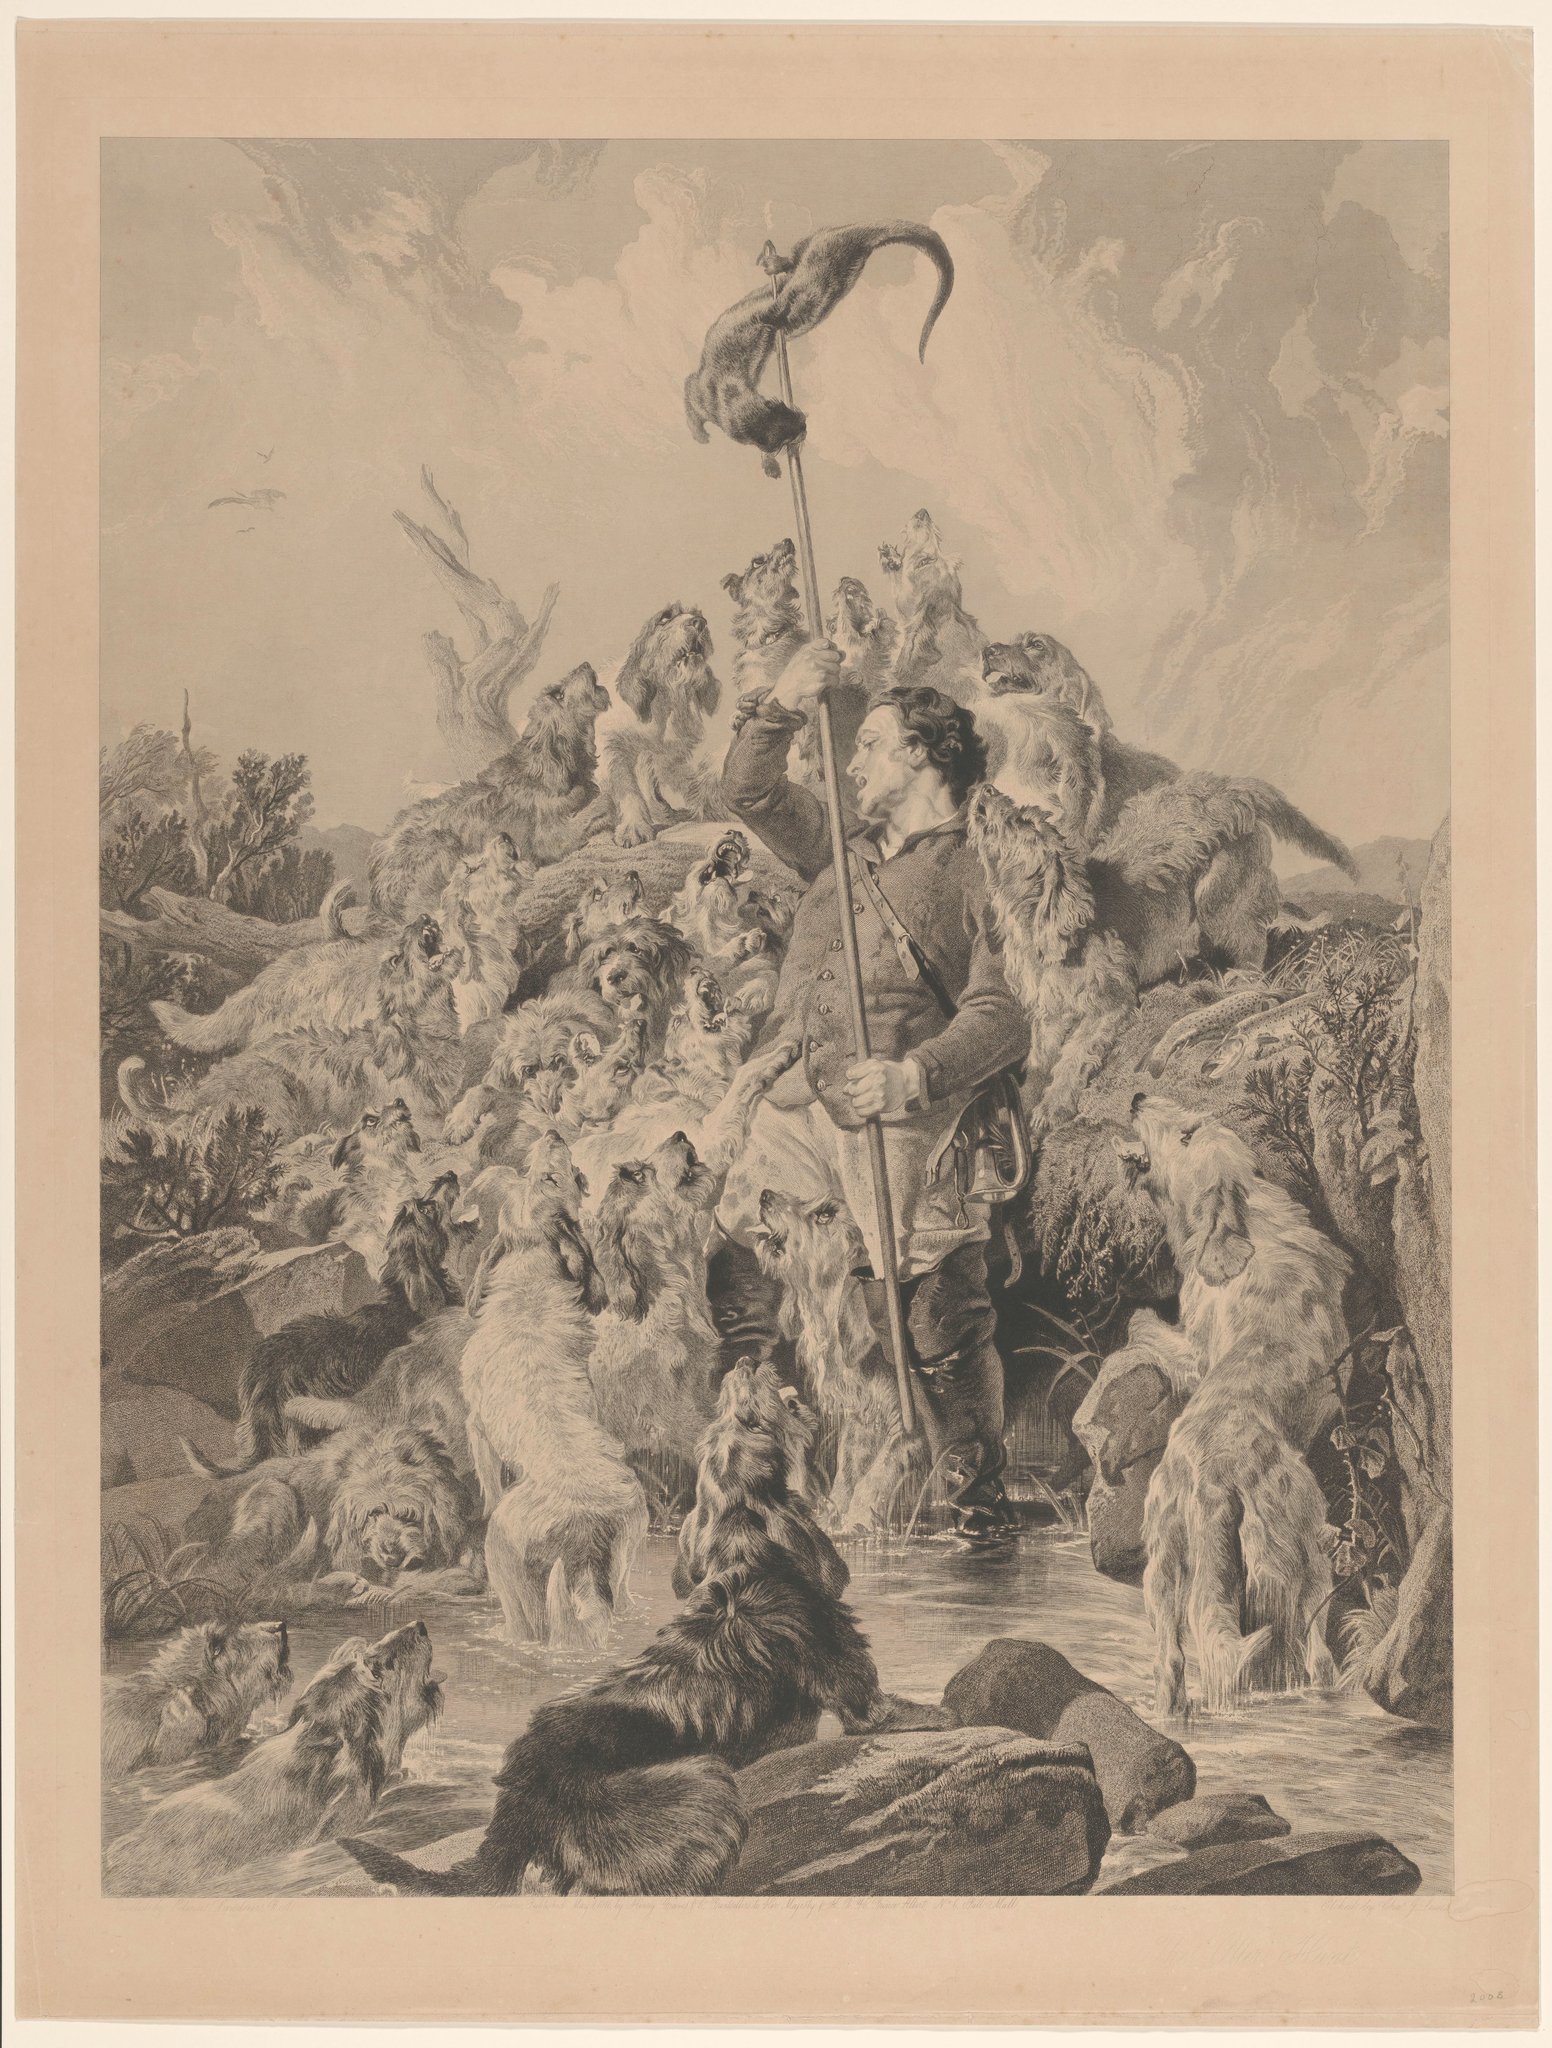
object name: print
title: Jacht op otters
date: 1816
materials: paper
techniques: etching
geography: london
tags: hunting, chase, beasts of prey, predatory animals: otter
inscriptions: collector's mark: Lugt 2228